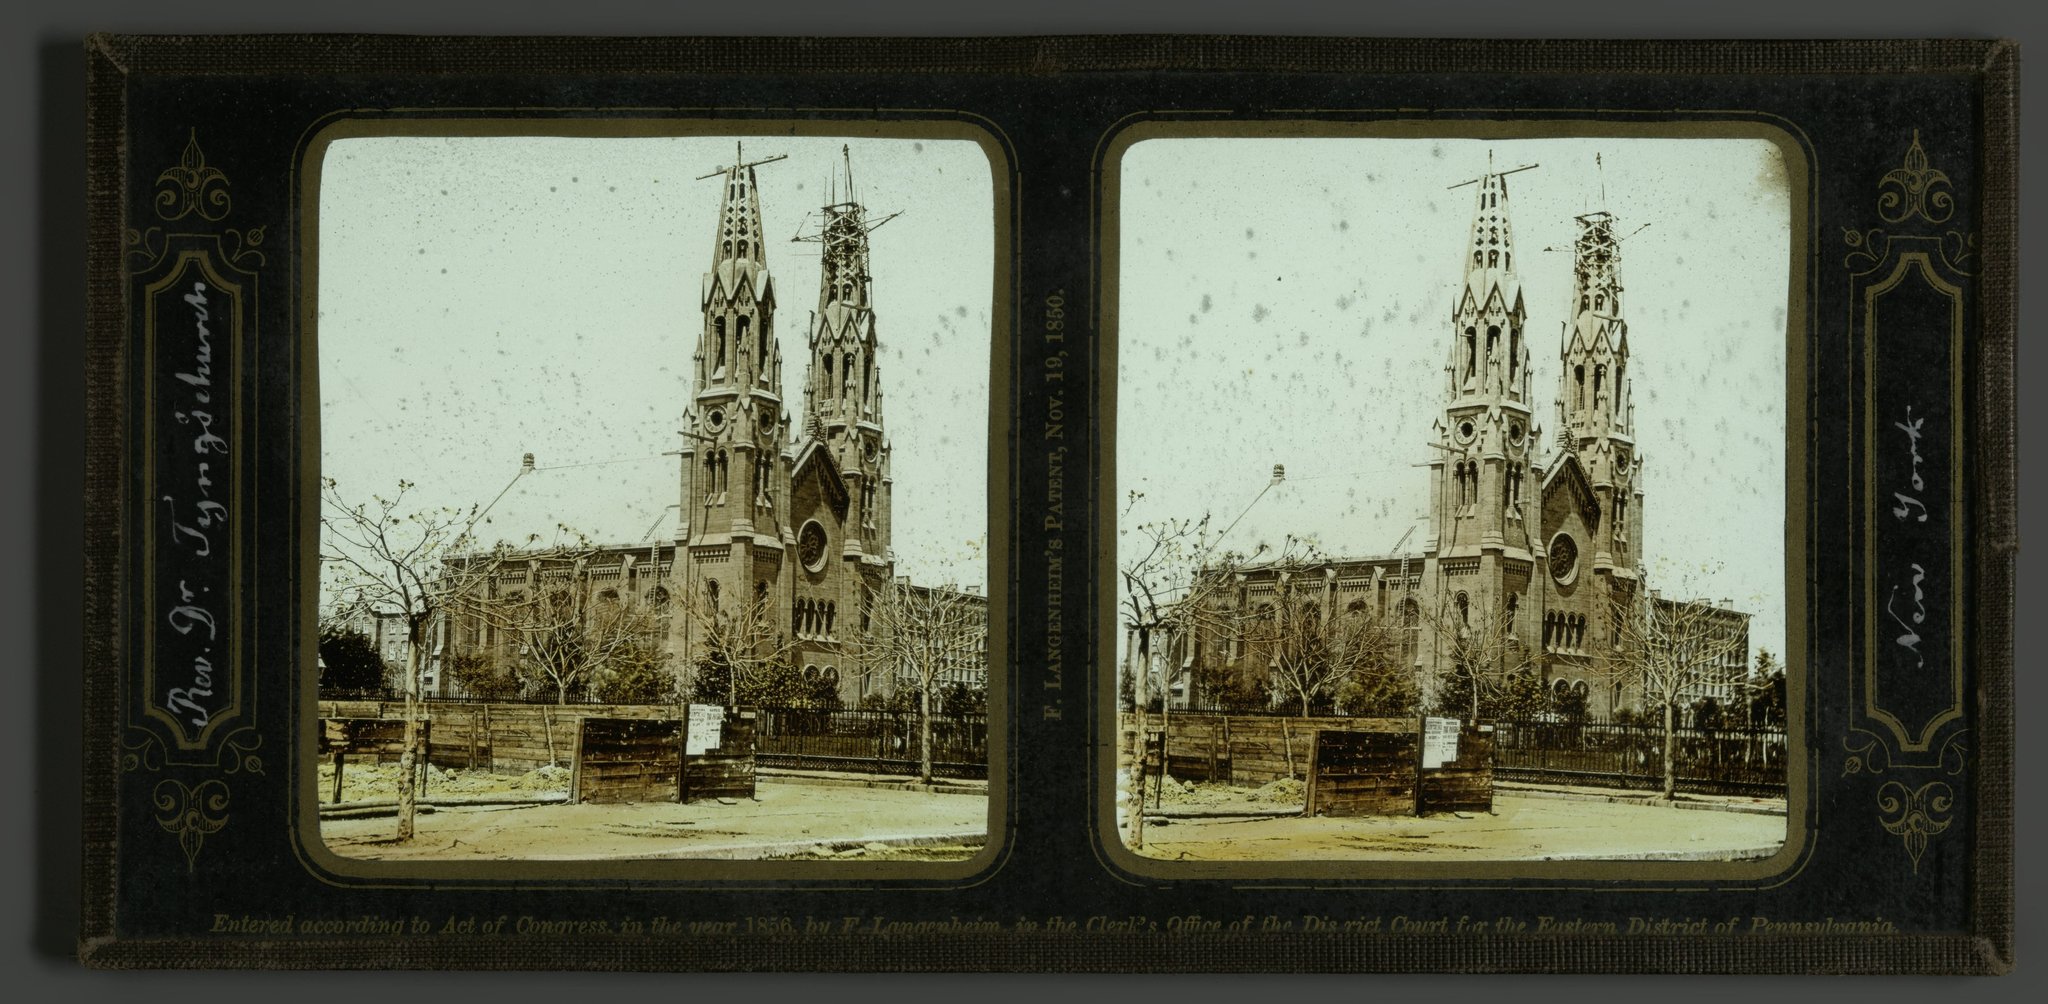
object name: stereoscopic photograph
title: St. George's Episcopal Church in Manhattan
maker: frederick langenheim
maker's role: fotograaf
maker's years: 1809-1879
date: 1856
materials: glass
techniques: hand coloring, slide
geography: manhattan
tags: church (exterior)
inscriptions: inscription: ‘Entered according to Act of Congress, in the year 1856, by F. Langenheim, in the Clerk's Office of the District Court for the Eastern District of Pennsylvania.’, inscription: ‘F. Langenheim's Patent, Nov. 19, 1850.’